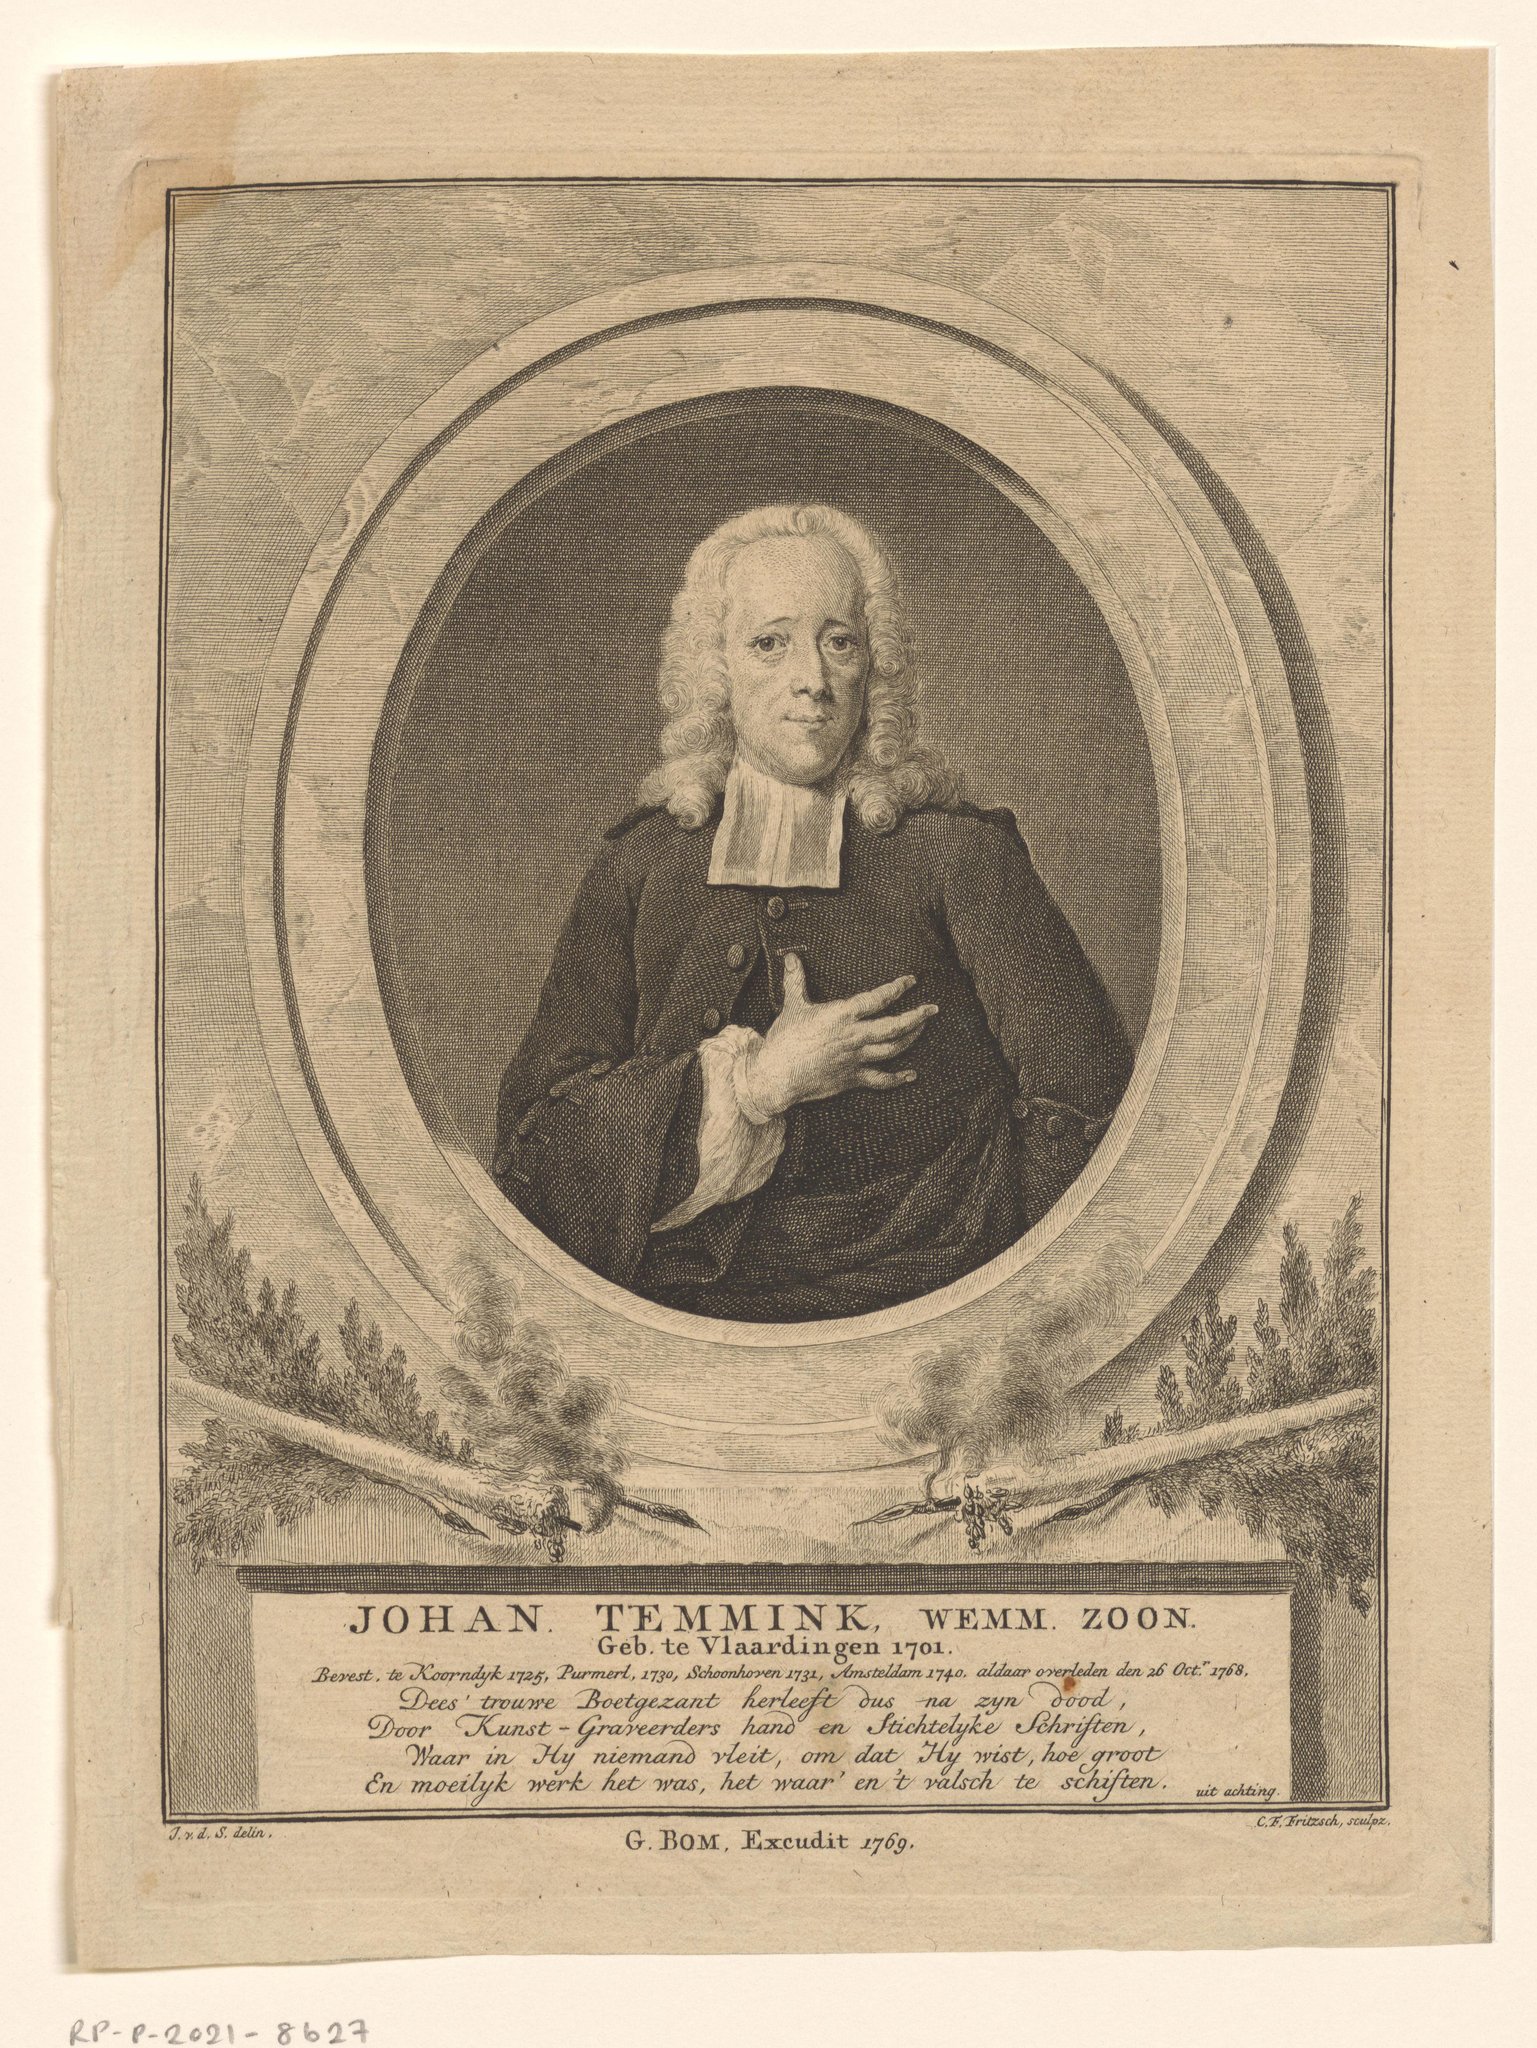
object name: print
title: Portret van Johan Temmink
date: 1769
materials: paper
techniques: engraving, etching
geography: amsterdam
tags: historical persons, functionaries and dignitaries ~ episcopal protestant churches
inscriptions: date